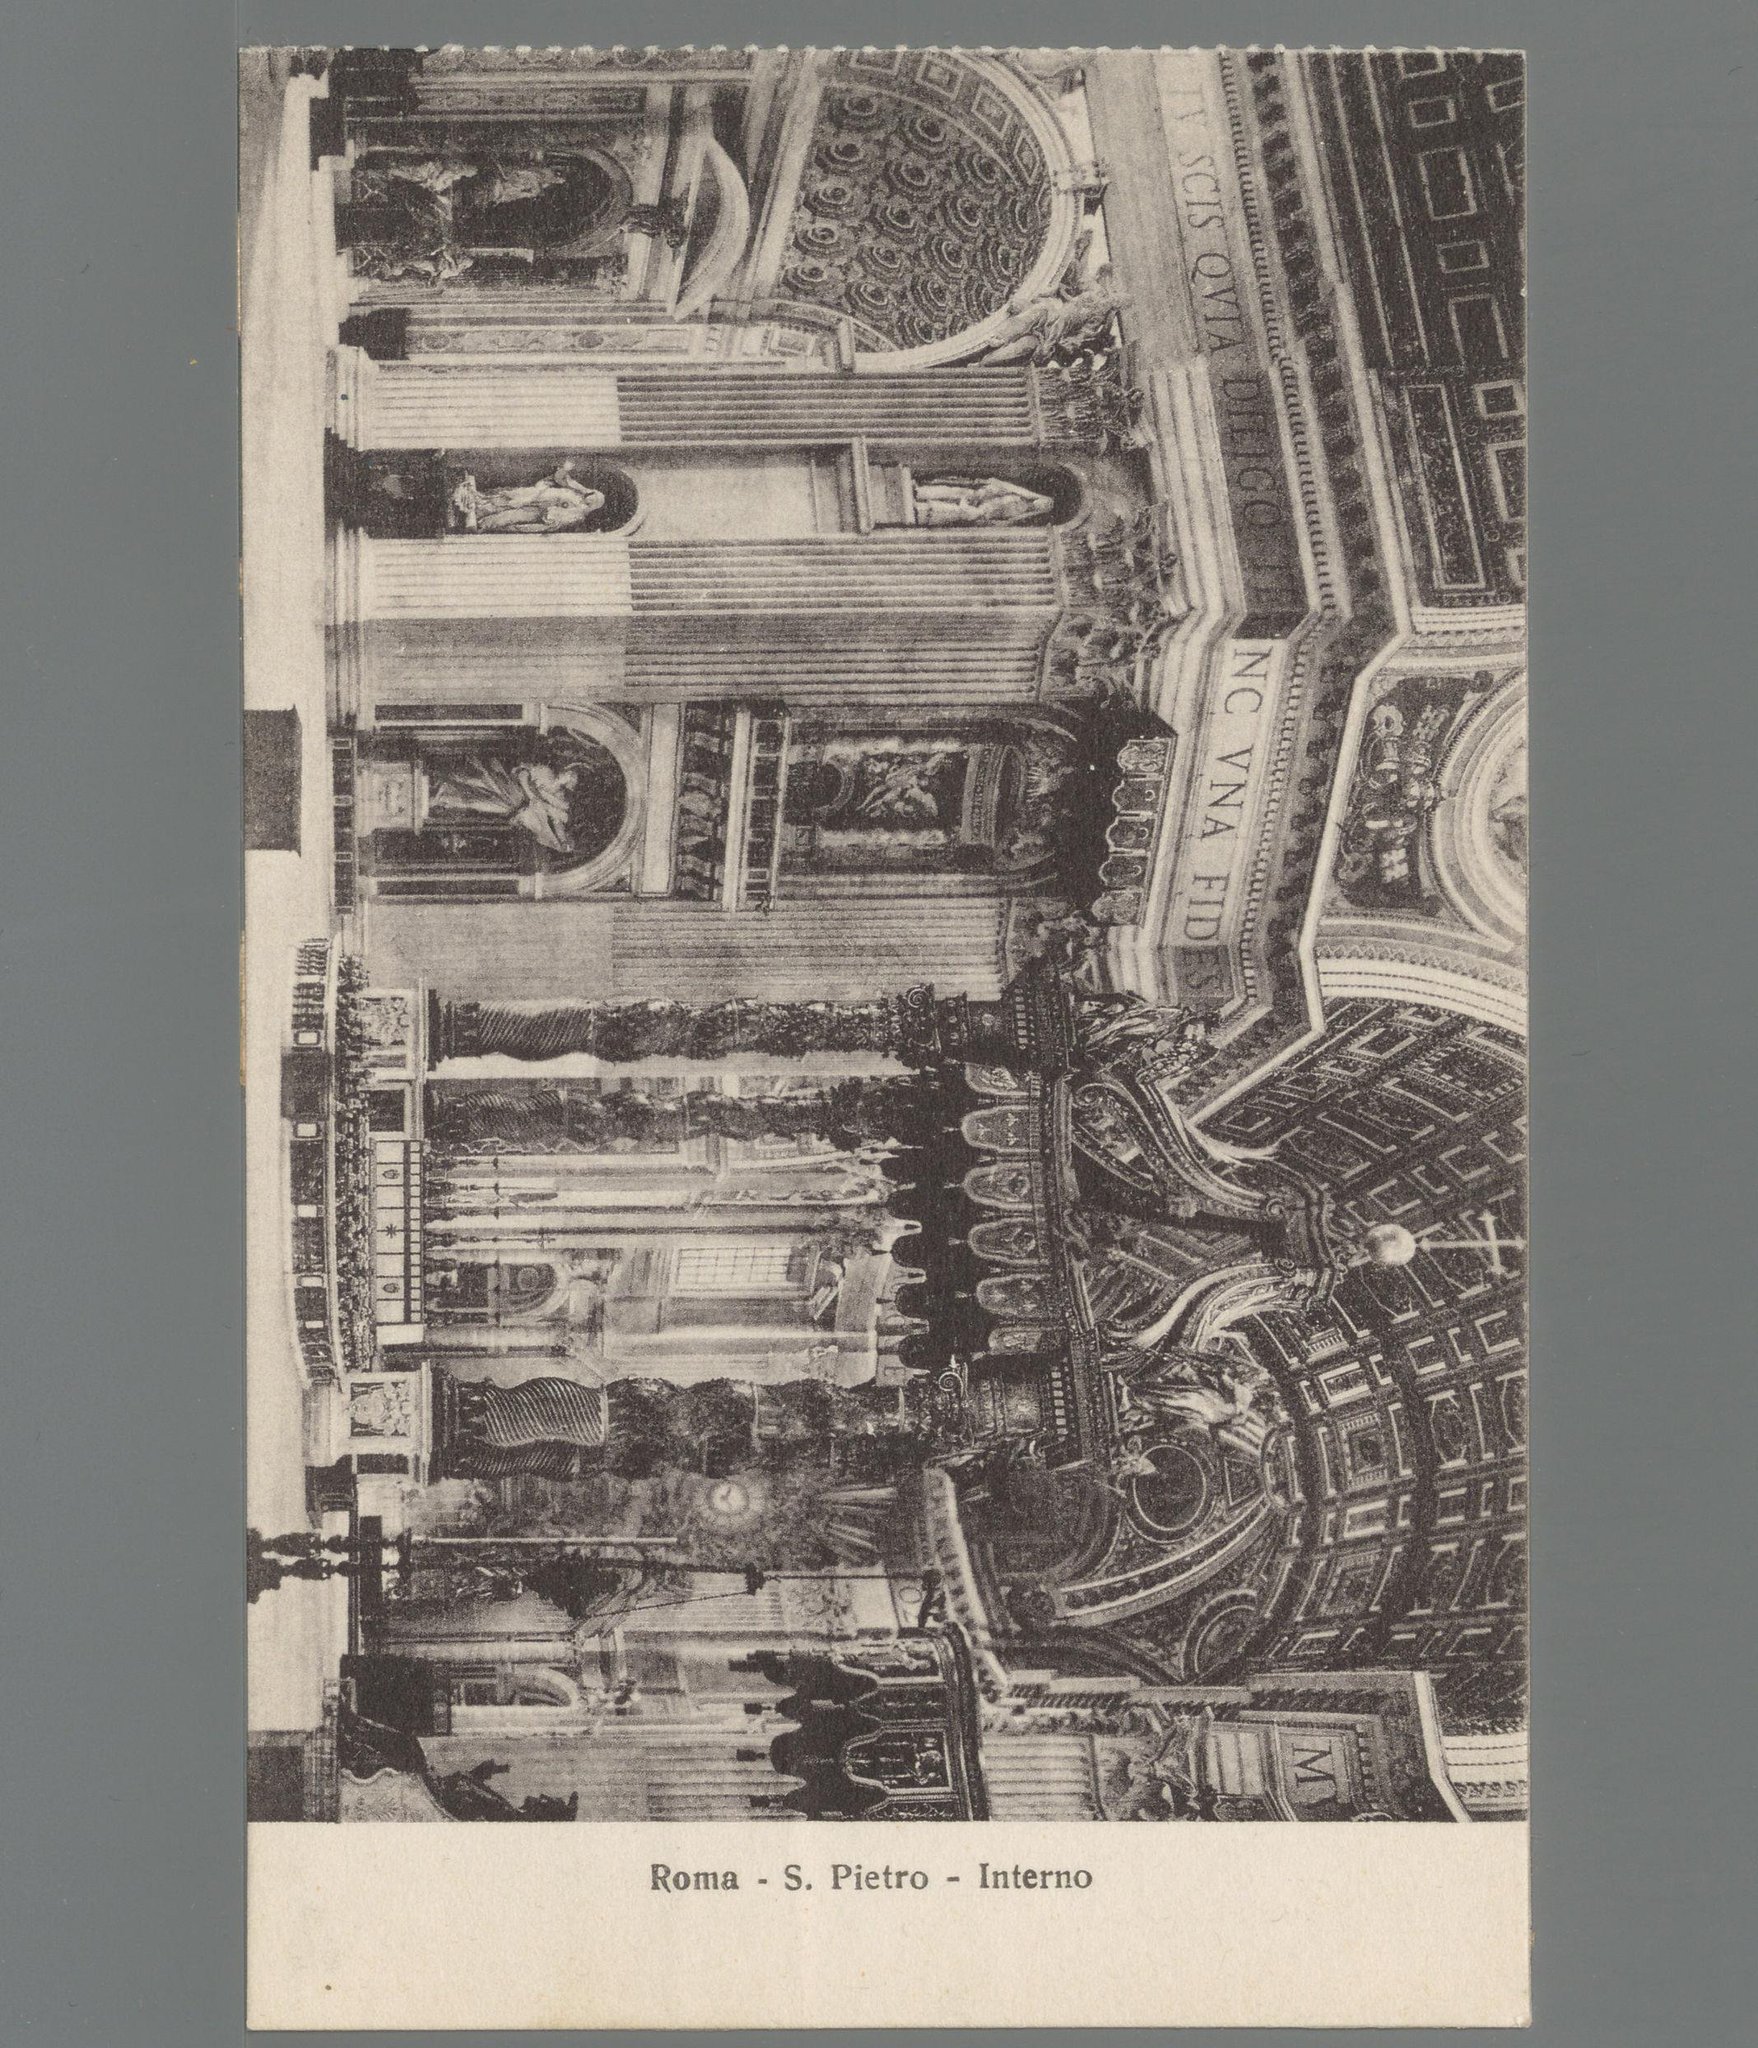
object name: photomechanical print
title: Roma. S. Pietro. Interno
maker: Anonymous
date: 1910-1930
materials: cardboard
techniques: photograph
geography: terni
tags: interior of church